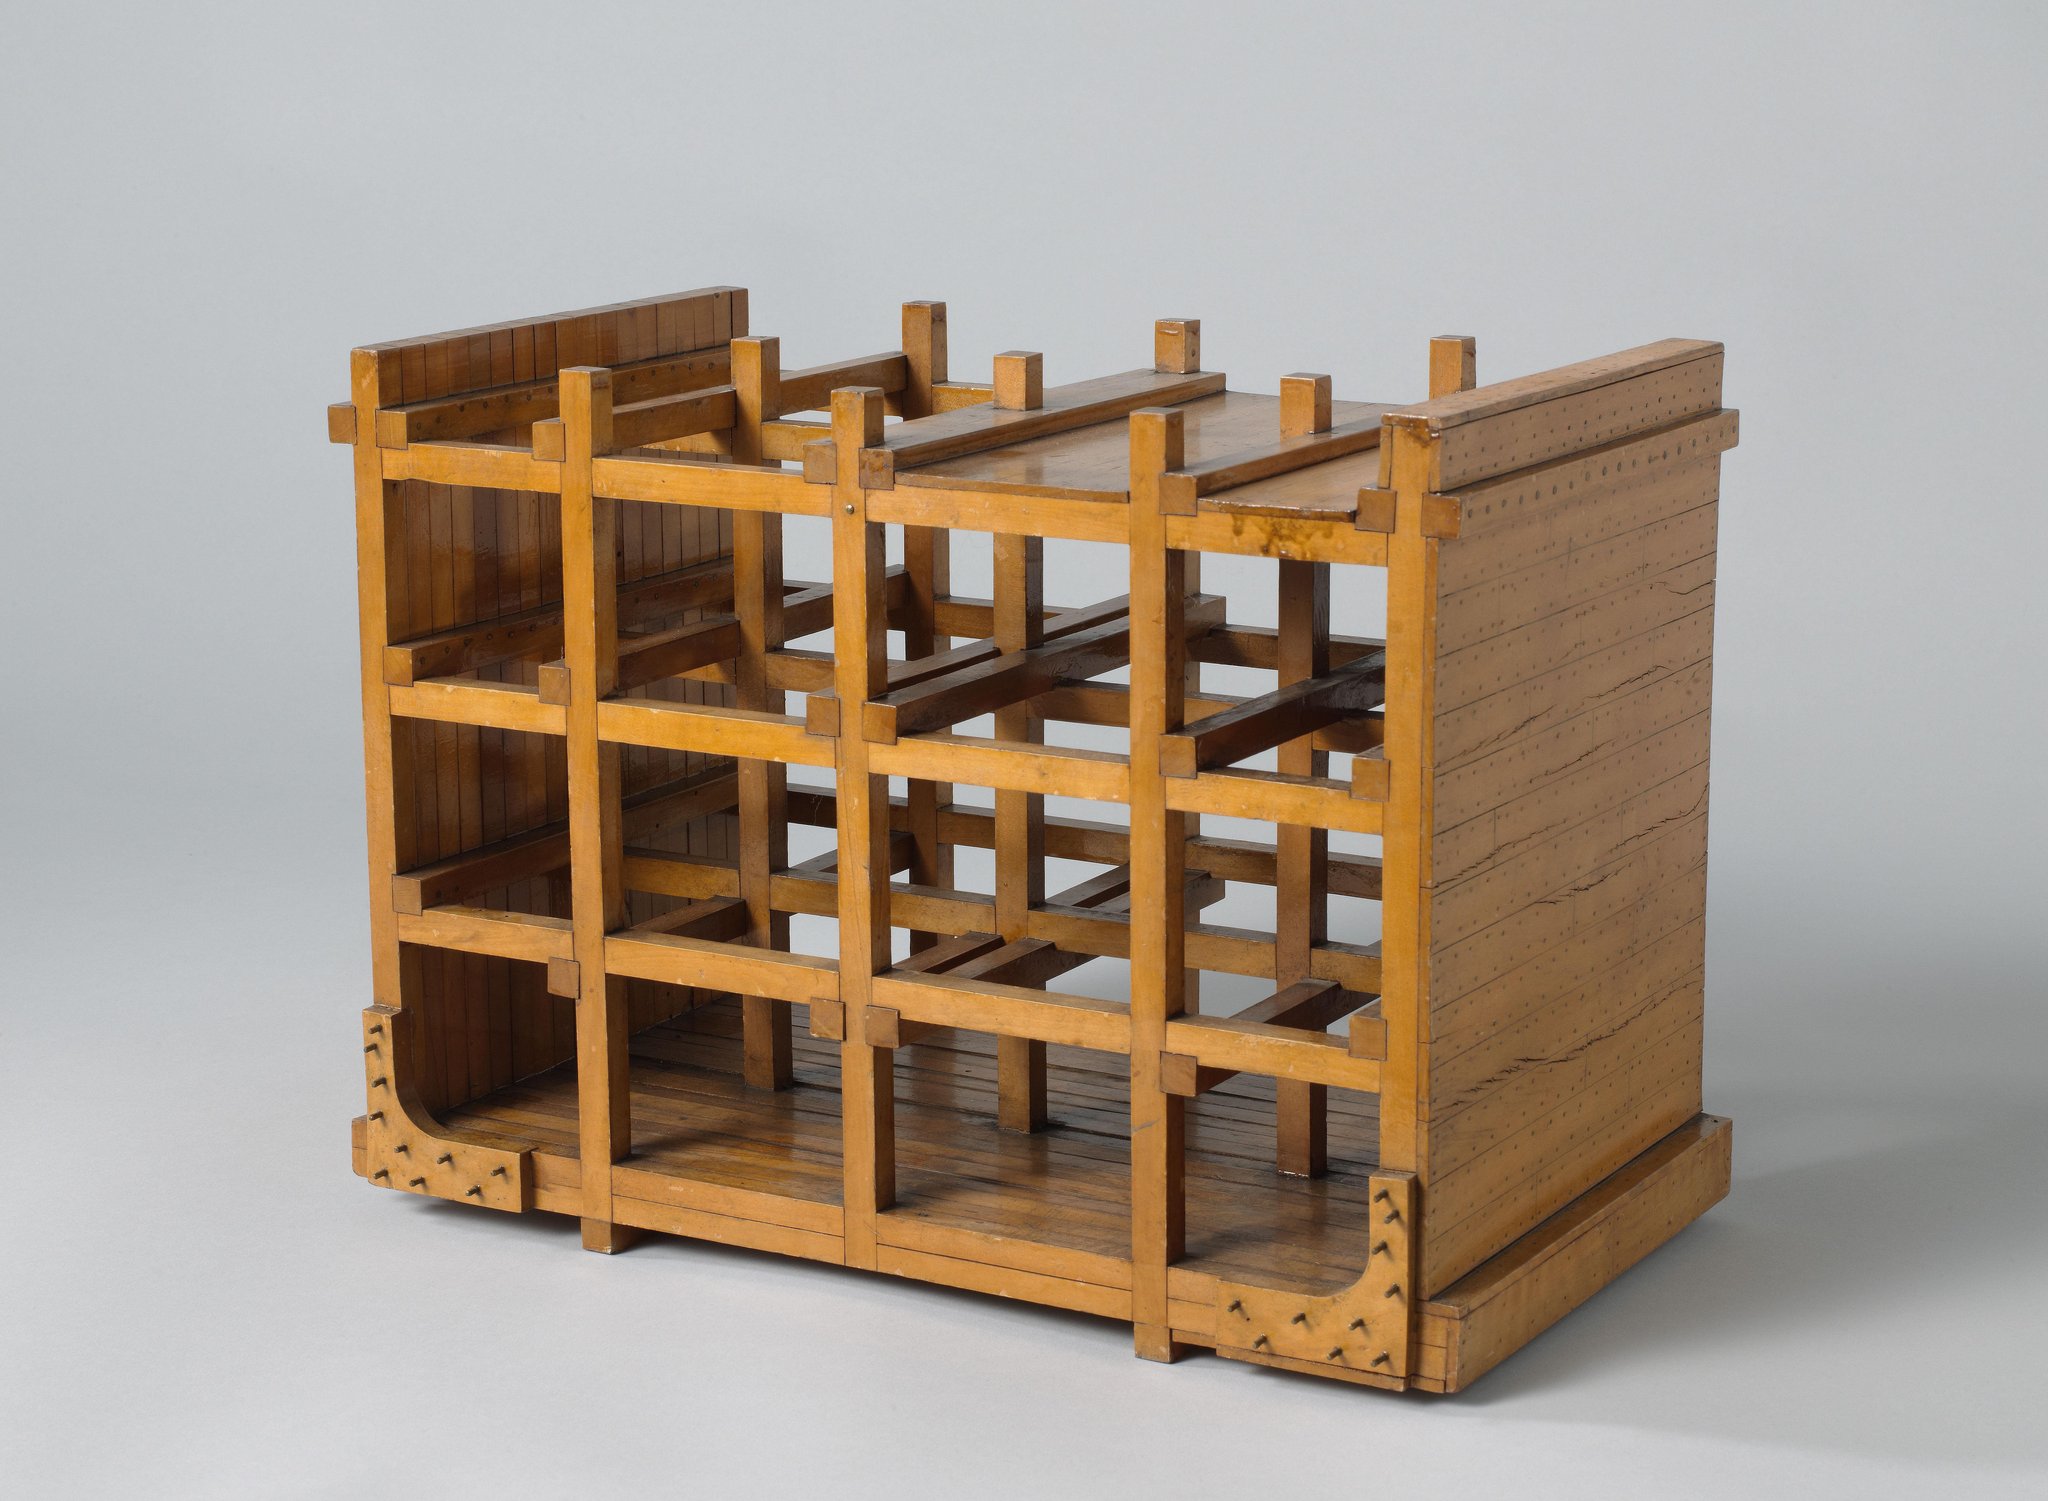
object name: demonstration model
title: Model of the Construction of a Timber Ship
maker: Anonymous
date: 1824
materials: brass, wood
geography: quebec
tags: columbus (schip)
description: Het houtschip Columbus werd in 1824 door Charles Wood op Anse du Fort, Isle of Orleans, vier mijl van Quebec, gebouwd. Houtschepen waren schepen opgebouwd uit hout voor de scheepsbouw, zowel rondhout als romphout, en werden bij aankomst uiteengenomen om het hout voor de handel te gebruiken; zij werden daarenboven met hout geladen. De voornaamste overweging voor hun bouw was het drukken van de vrachtkosten van scheepshout, maar op deze wijze konden ook de invoerrechten op timmerhout omzeild worden. De reis van de Columbus naar Londen was zo'n succes, dat de eigenaars tegen het advies van Wood in afzagen van het oorspronkelijke plan om het schip af te breken en het terugstuurden voor een tweede lading hout. Deze reis werd fataal.